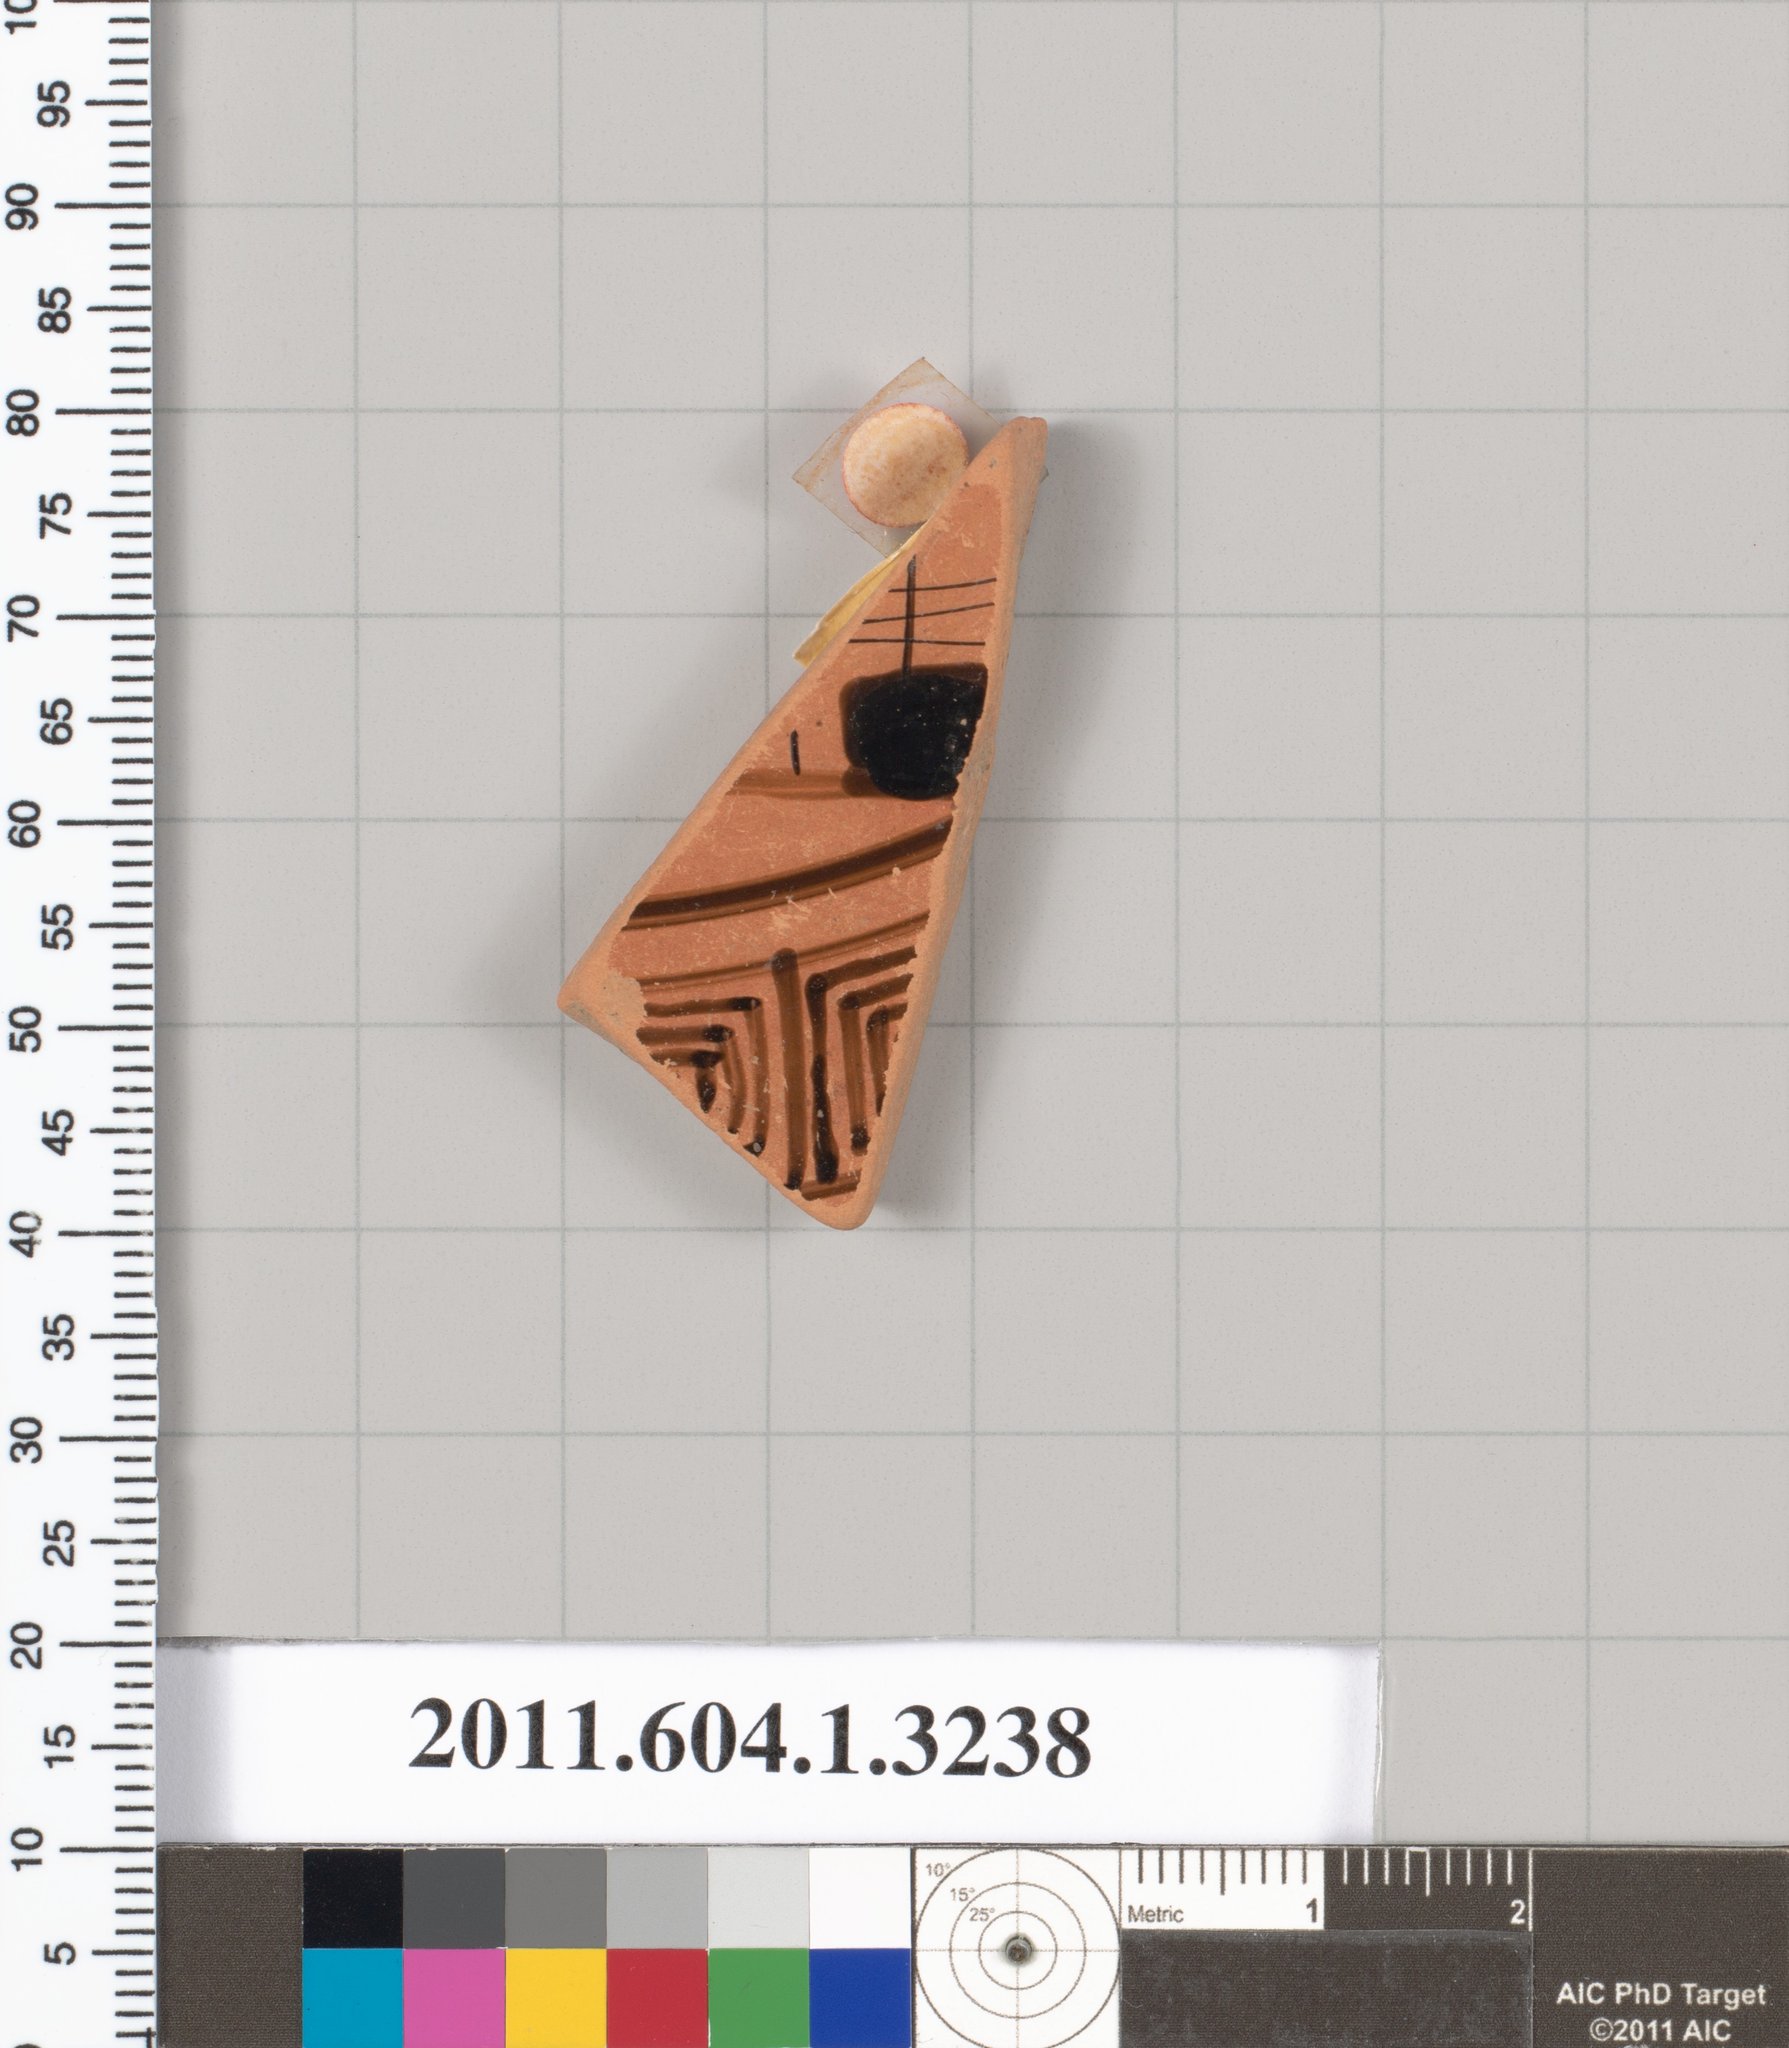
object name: kylix fragment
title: Terracotta fragment of a kylix (drinking cup)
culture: greek, attic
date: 467-435 BCE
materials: terracotta